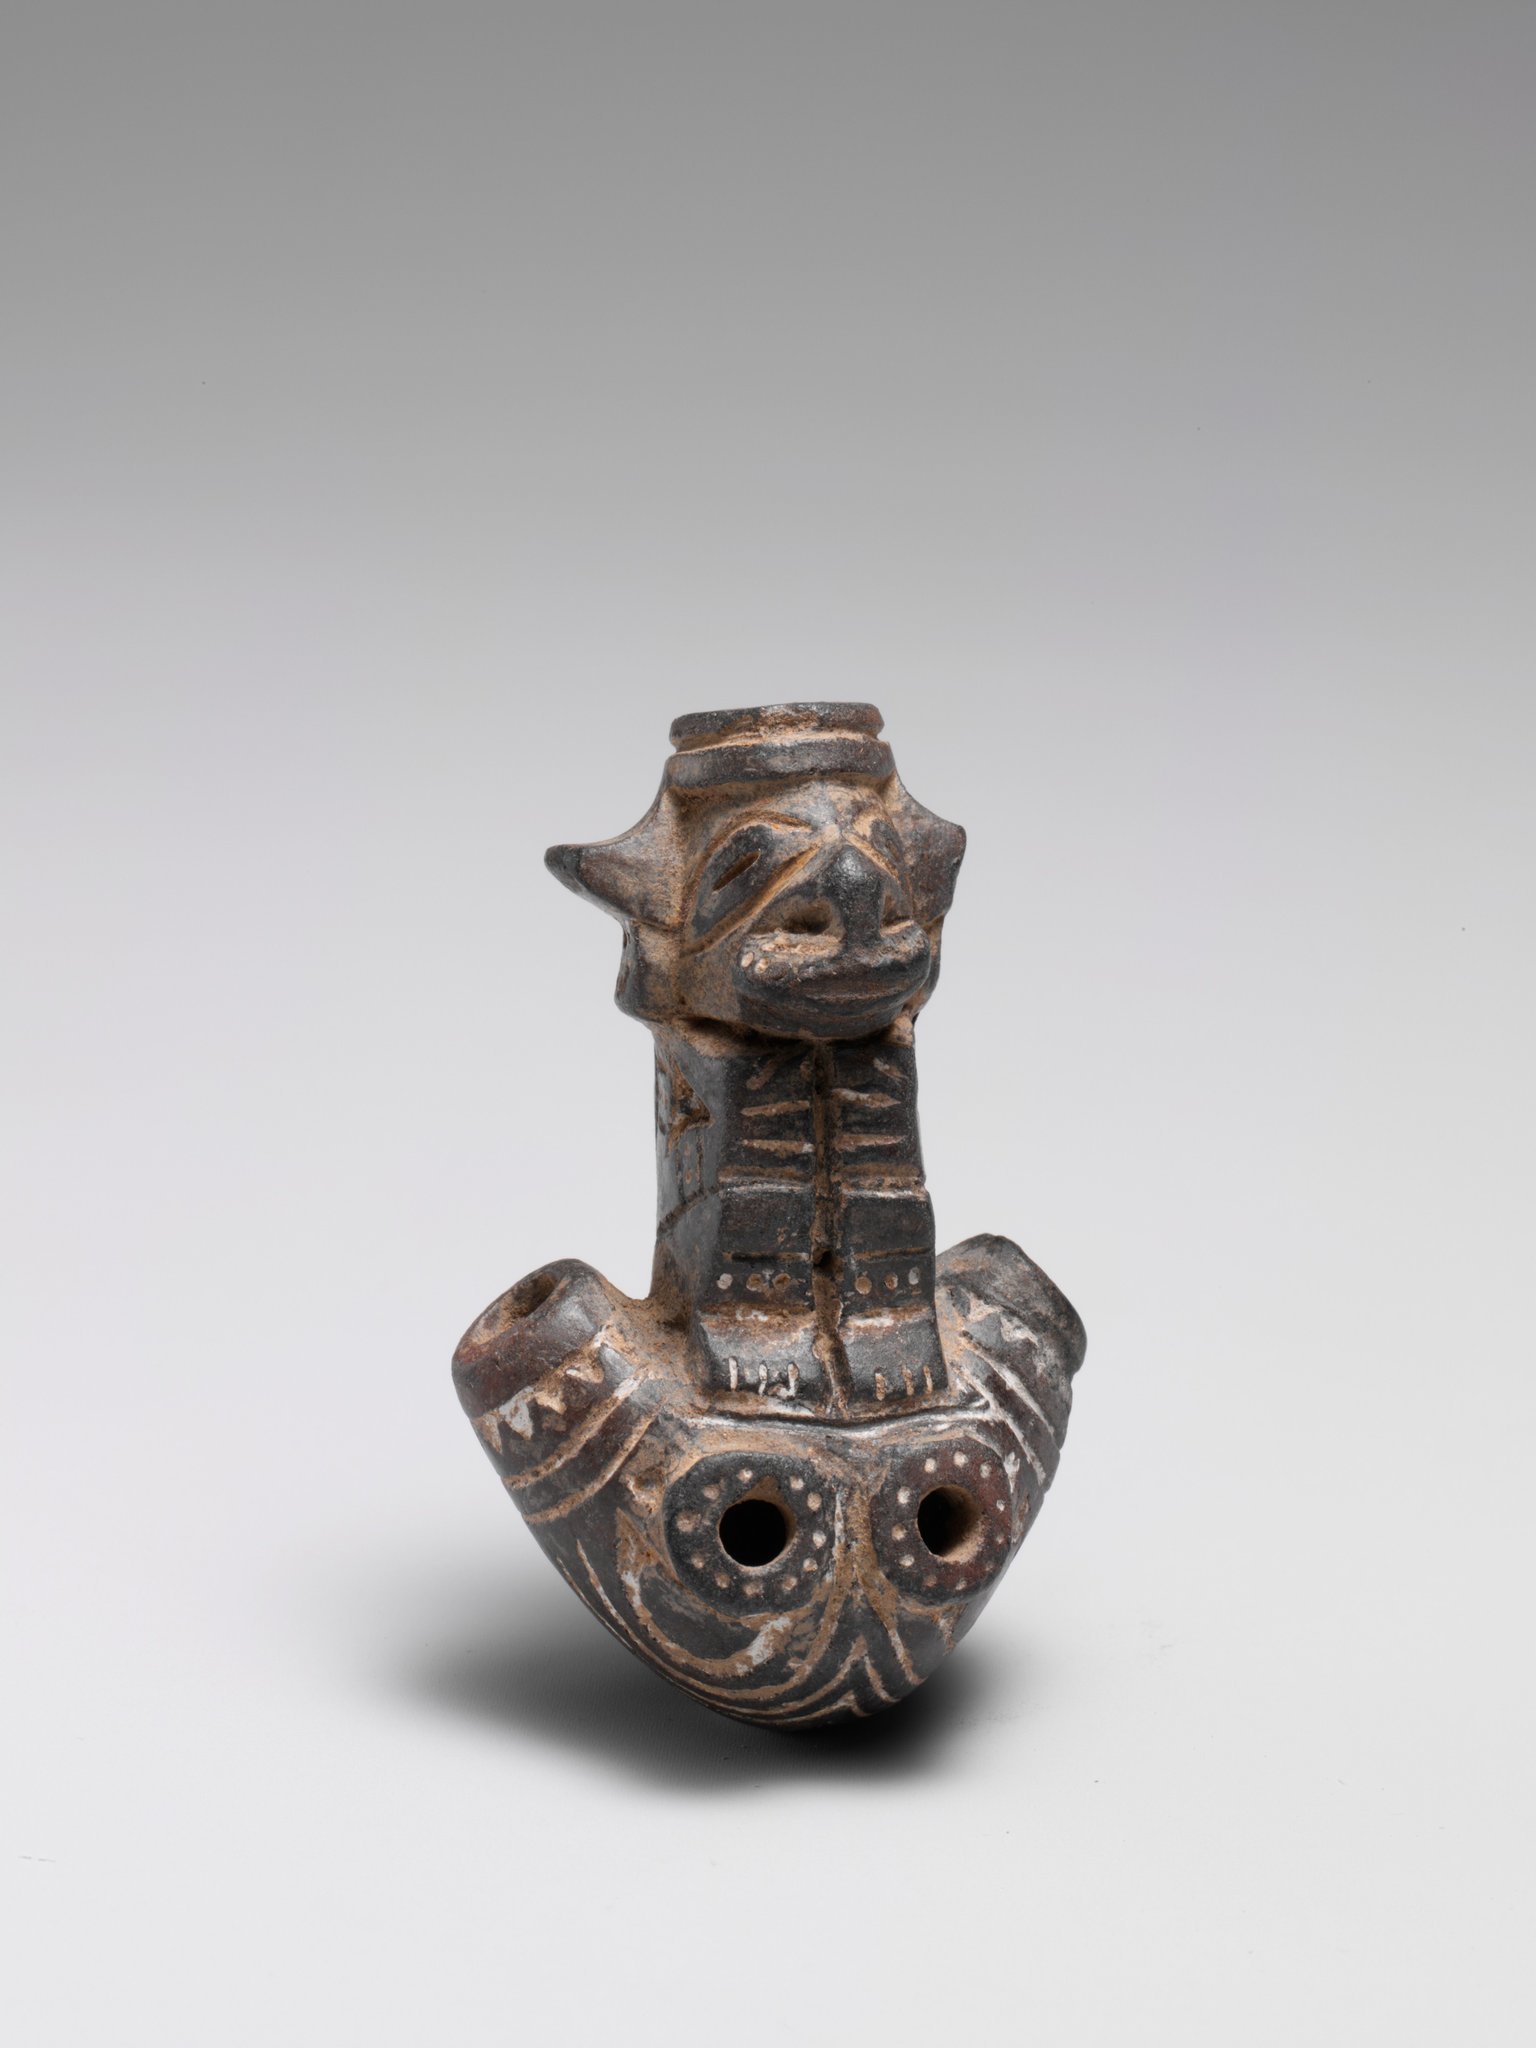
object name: ocarina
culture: tairona people or la aguja style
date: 1300-1500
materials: ceramic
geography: colombia